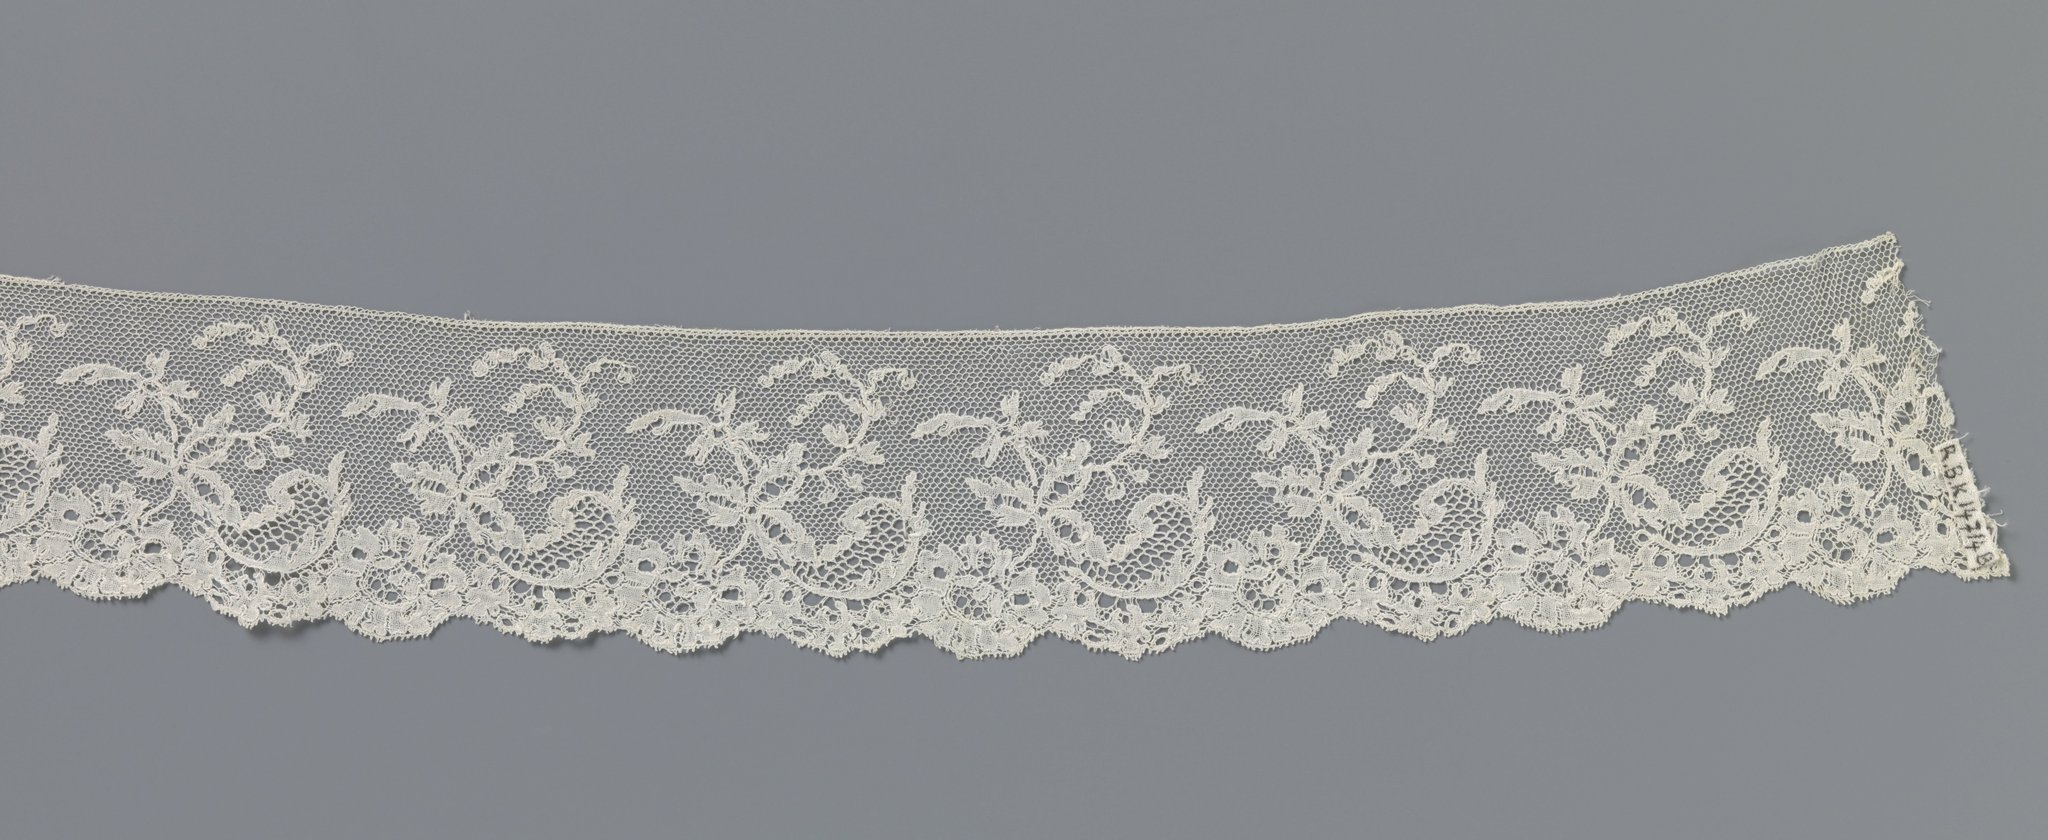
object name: strip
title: Strook kloskant met hangende bloem en komma-vormig motief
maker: Anonymous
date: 1800-1809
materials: cotton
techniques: lace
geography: lille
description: Strook naturelkleurige kloskant: Rijselse kant. Het zich herhalende patroon bestaat uit een hangende bloem aan een gebogen steel met bovenaan een omhoogkrullende zijtak. Tussen de opeenvolgende bloemen ligt een komma-vormig motief. De motieven zijn dicht op elkaar geplaatst en zijn met elkaar verbonden door een fijne traliegrond, een tulegrond. De motieven zijn gemaakt in linnenslag met enkele grote uitsparingen en dikkere contourdraden. Er zijn enkele siergronden toegepast, onder andere in het komma-vormige motief en het bloemhart. De bovenzijde is recht afgewerkt. De geschulpte onderzijde komt voort uit het patroon en is afgewerkt met picots.